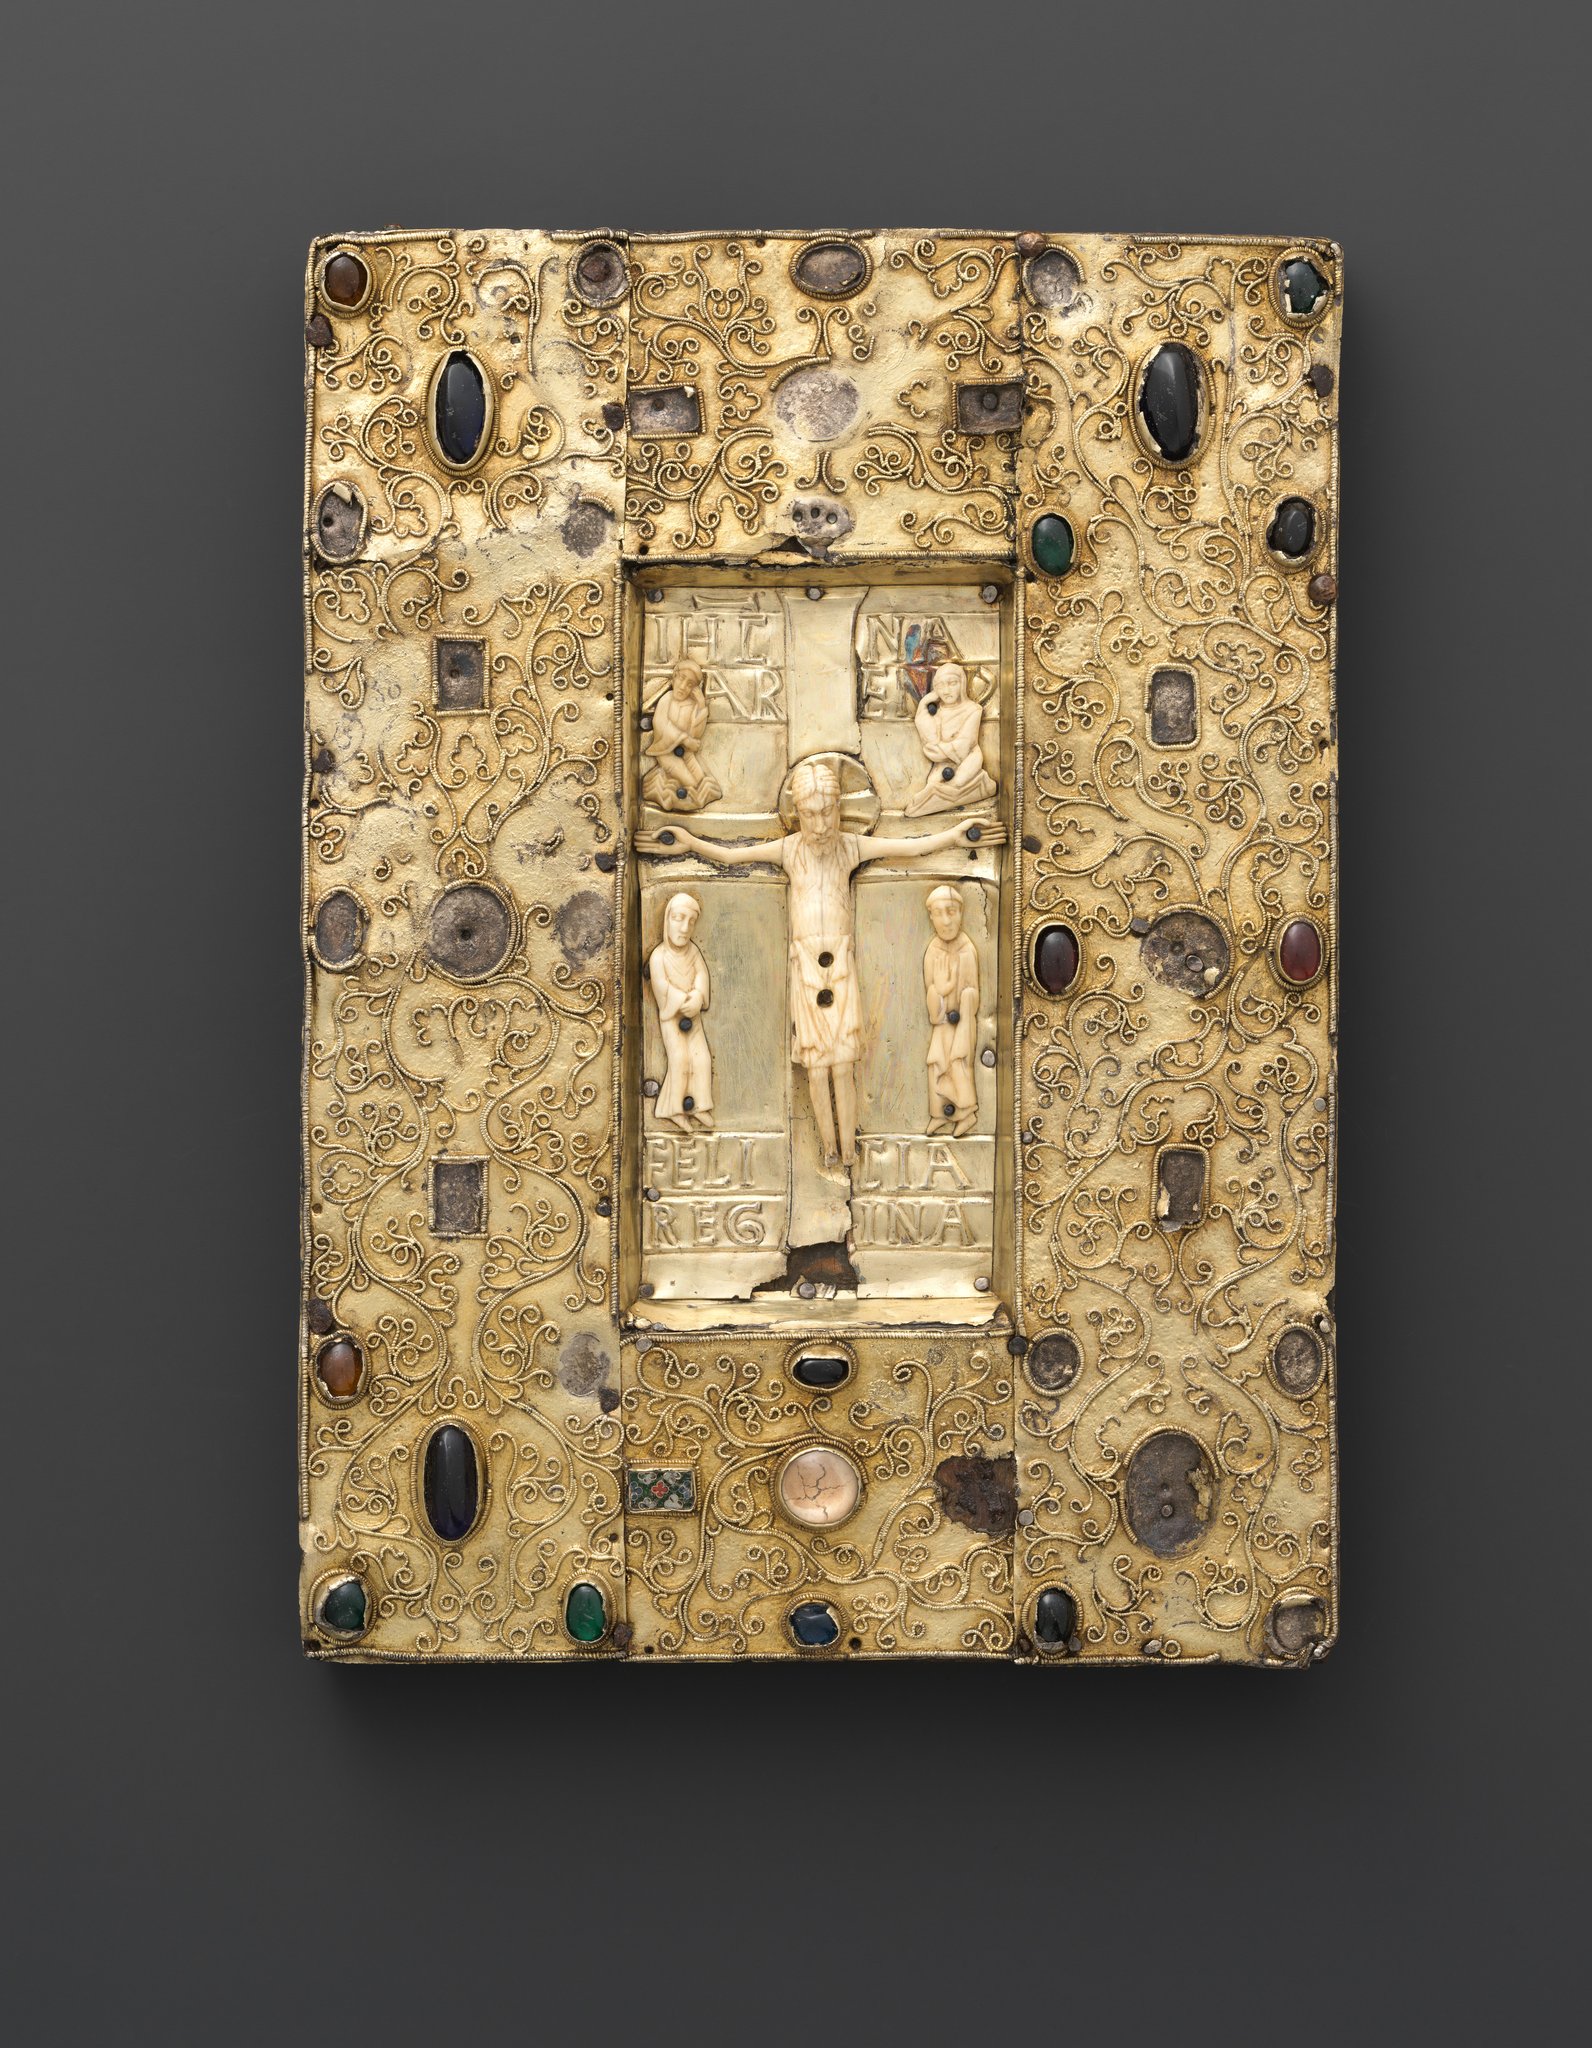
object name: panel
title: Panel with an Ivory Crucifixion Scene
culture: spanish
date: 1067-1100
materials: enamel, glass, ivory, wood, silver gilt, stone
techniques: enamel, filigree, gilding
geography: spain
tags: christ,virgin mary,crucifixion,saints